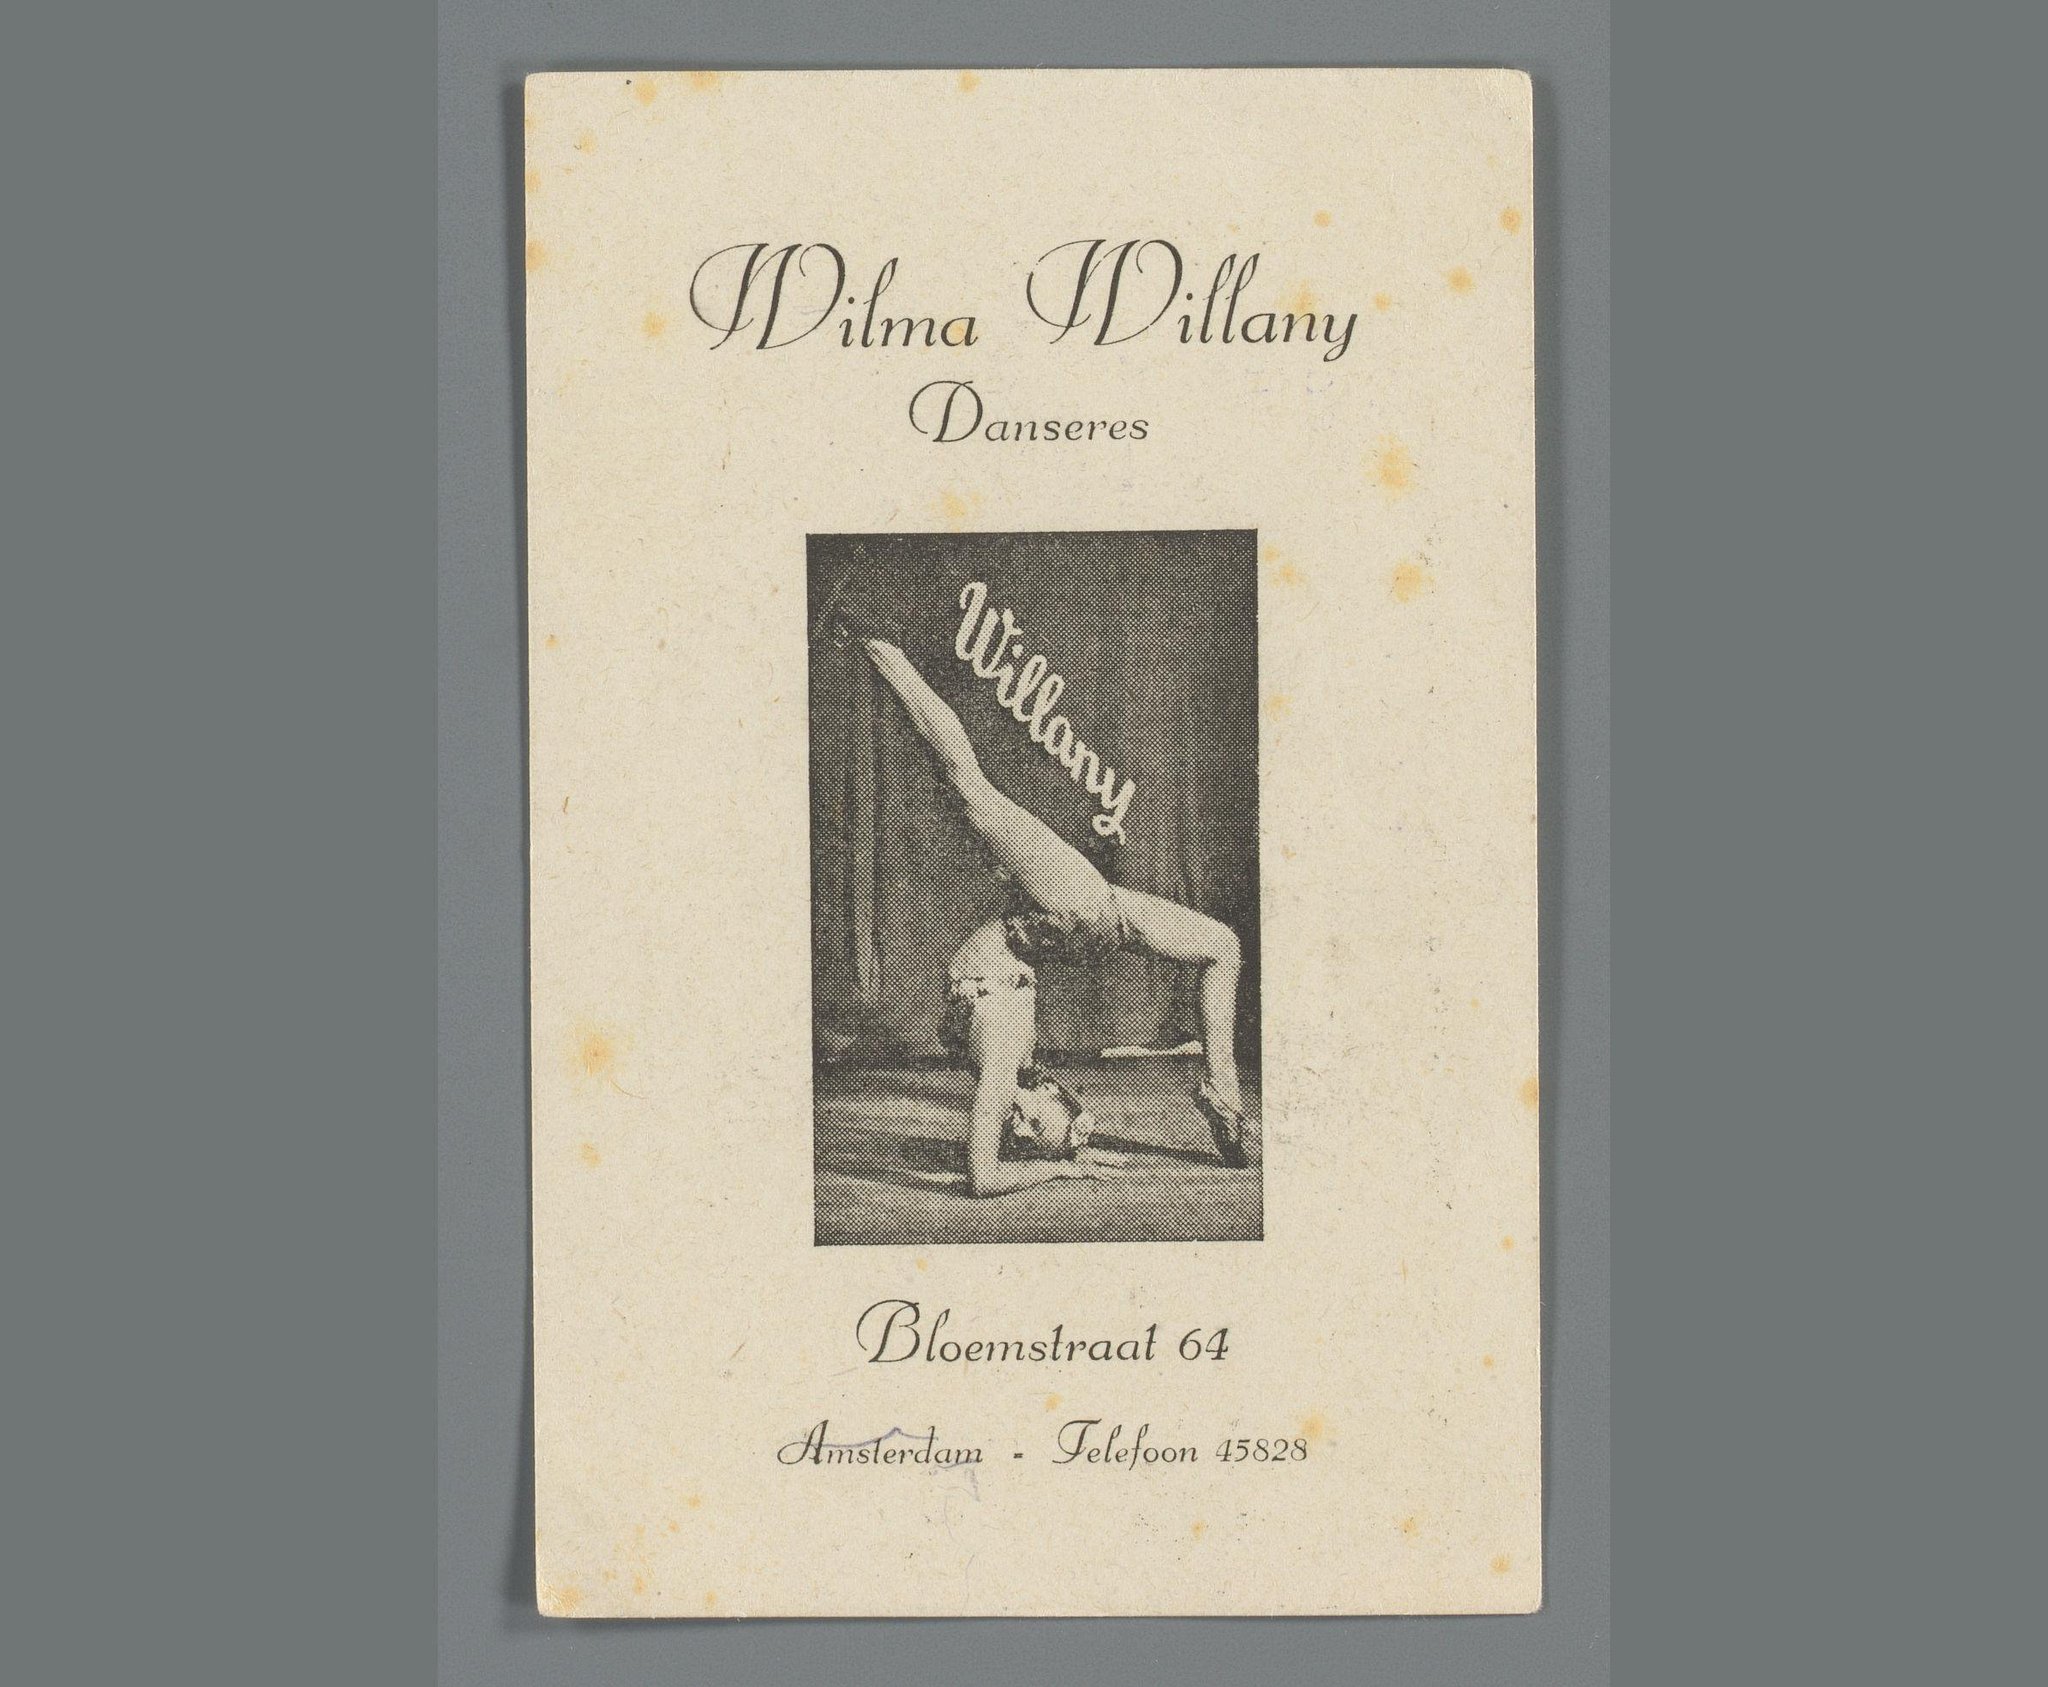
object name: photomechanical print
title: Visitekaart van danseres Wilma Willany, met jaarkalender op verso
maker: Anonymous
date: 1946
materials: paper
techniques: letterpress printing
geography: netherlands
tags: female dancer